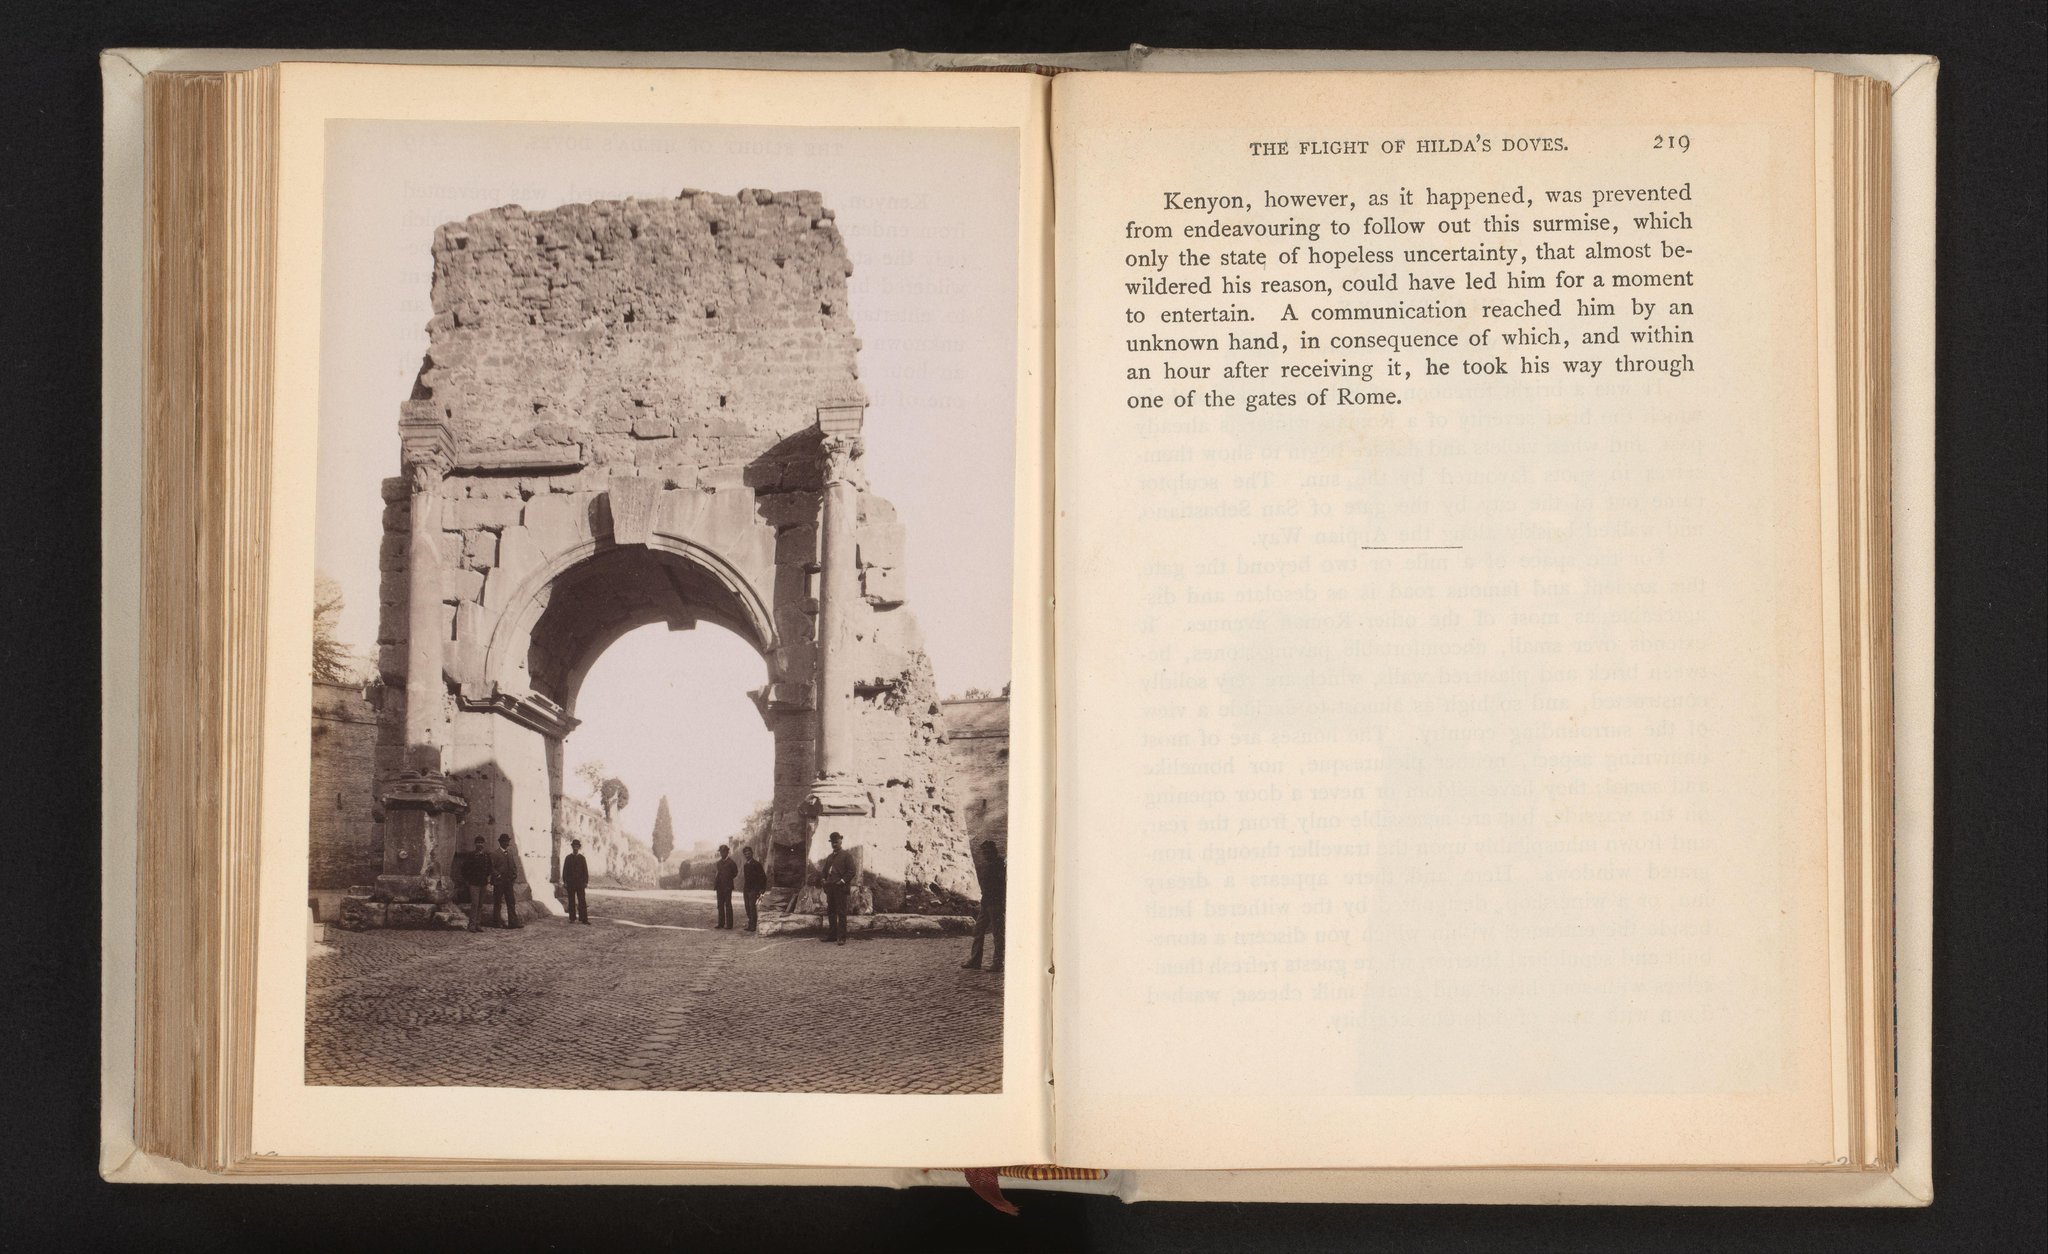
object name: page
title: Gezicht op een oude stadspoort van Rome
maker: Anonymous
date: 1850-1860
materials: photographic support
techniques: albumen print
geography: rome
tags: city-gate, rome